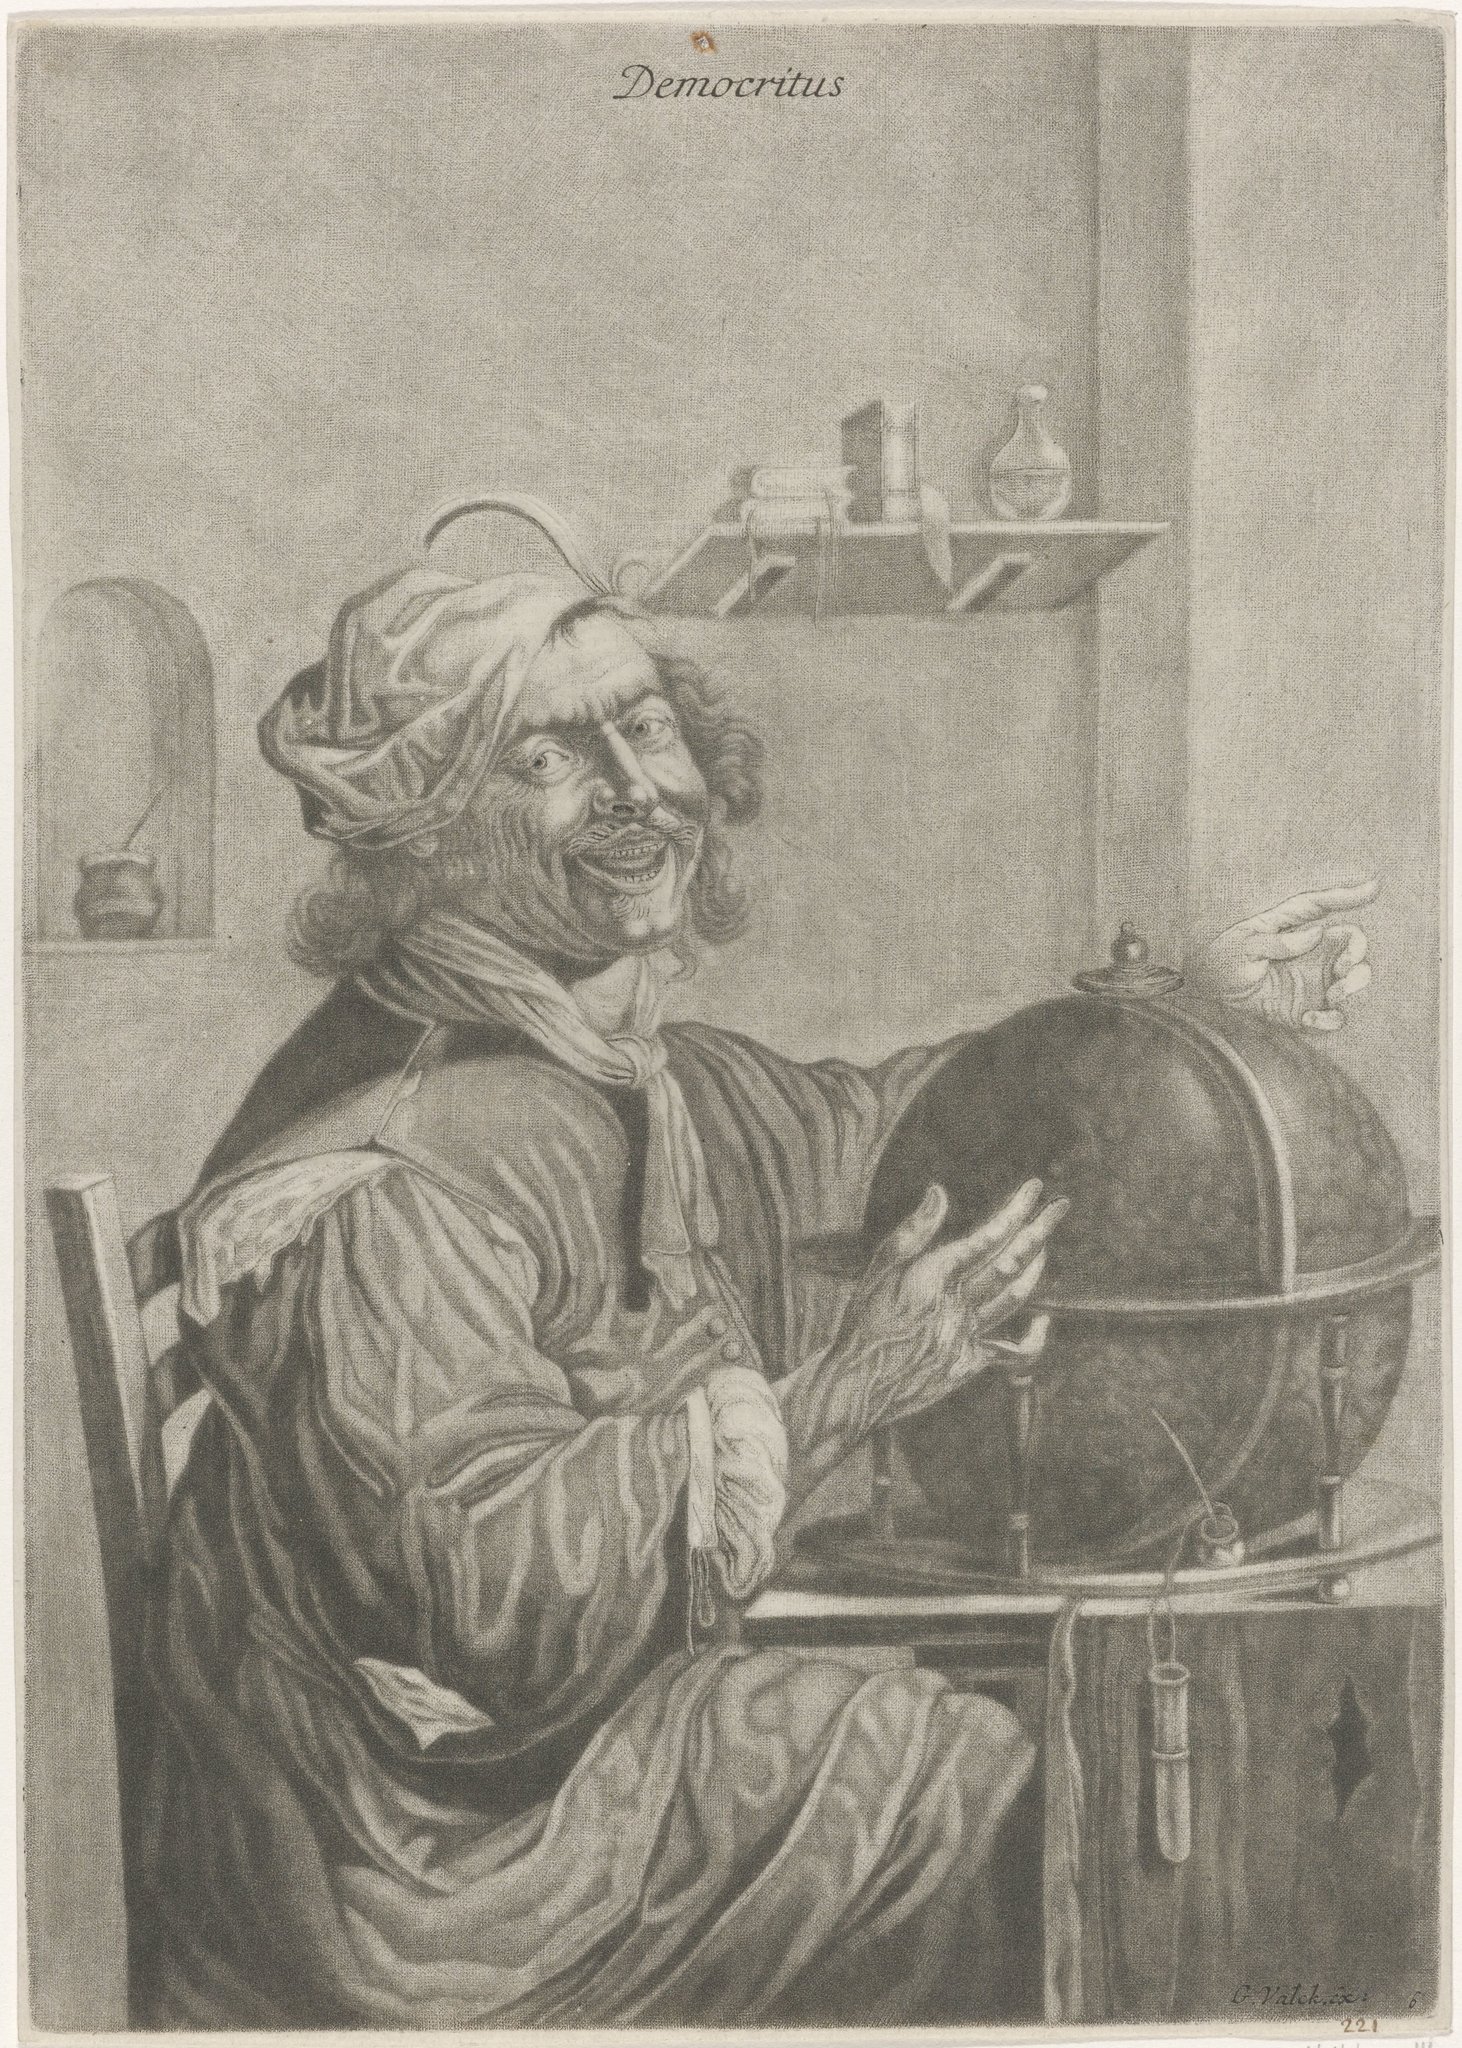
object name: print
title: Democritus lacht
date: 1661-1726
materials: paper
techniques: engraving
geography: amsterdam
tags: laughing, globe, (story of) democritus, the philosopher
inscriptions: collector's mark: Lugt 240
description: De Griekse filosoof Democritus zit in zijn werkkamer bij een aardbol en lacht.